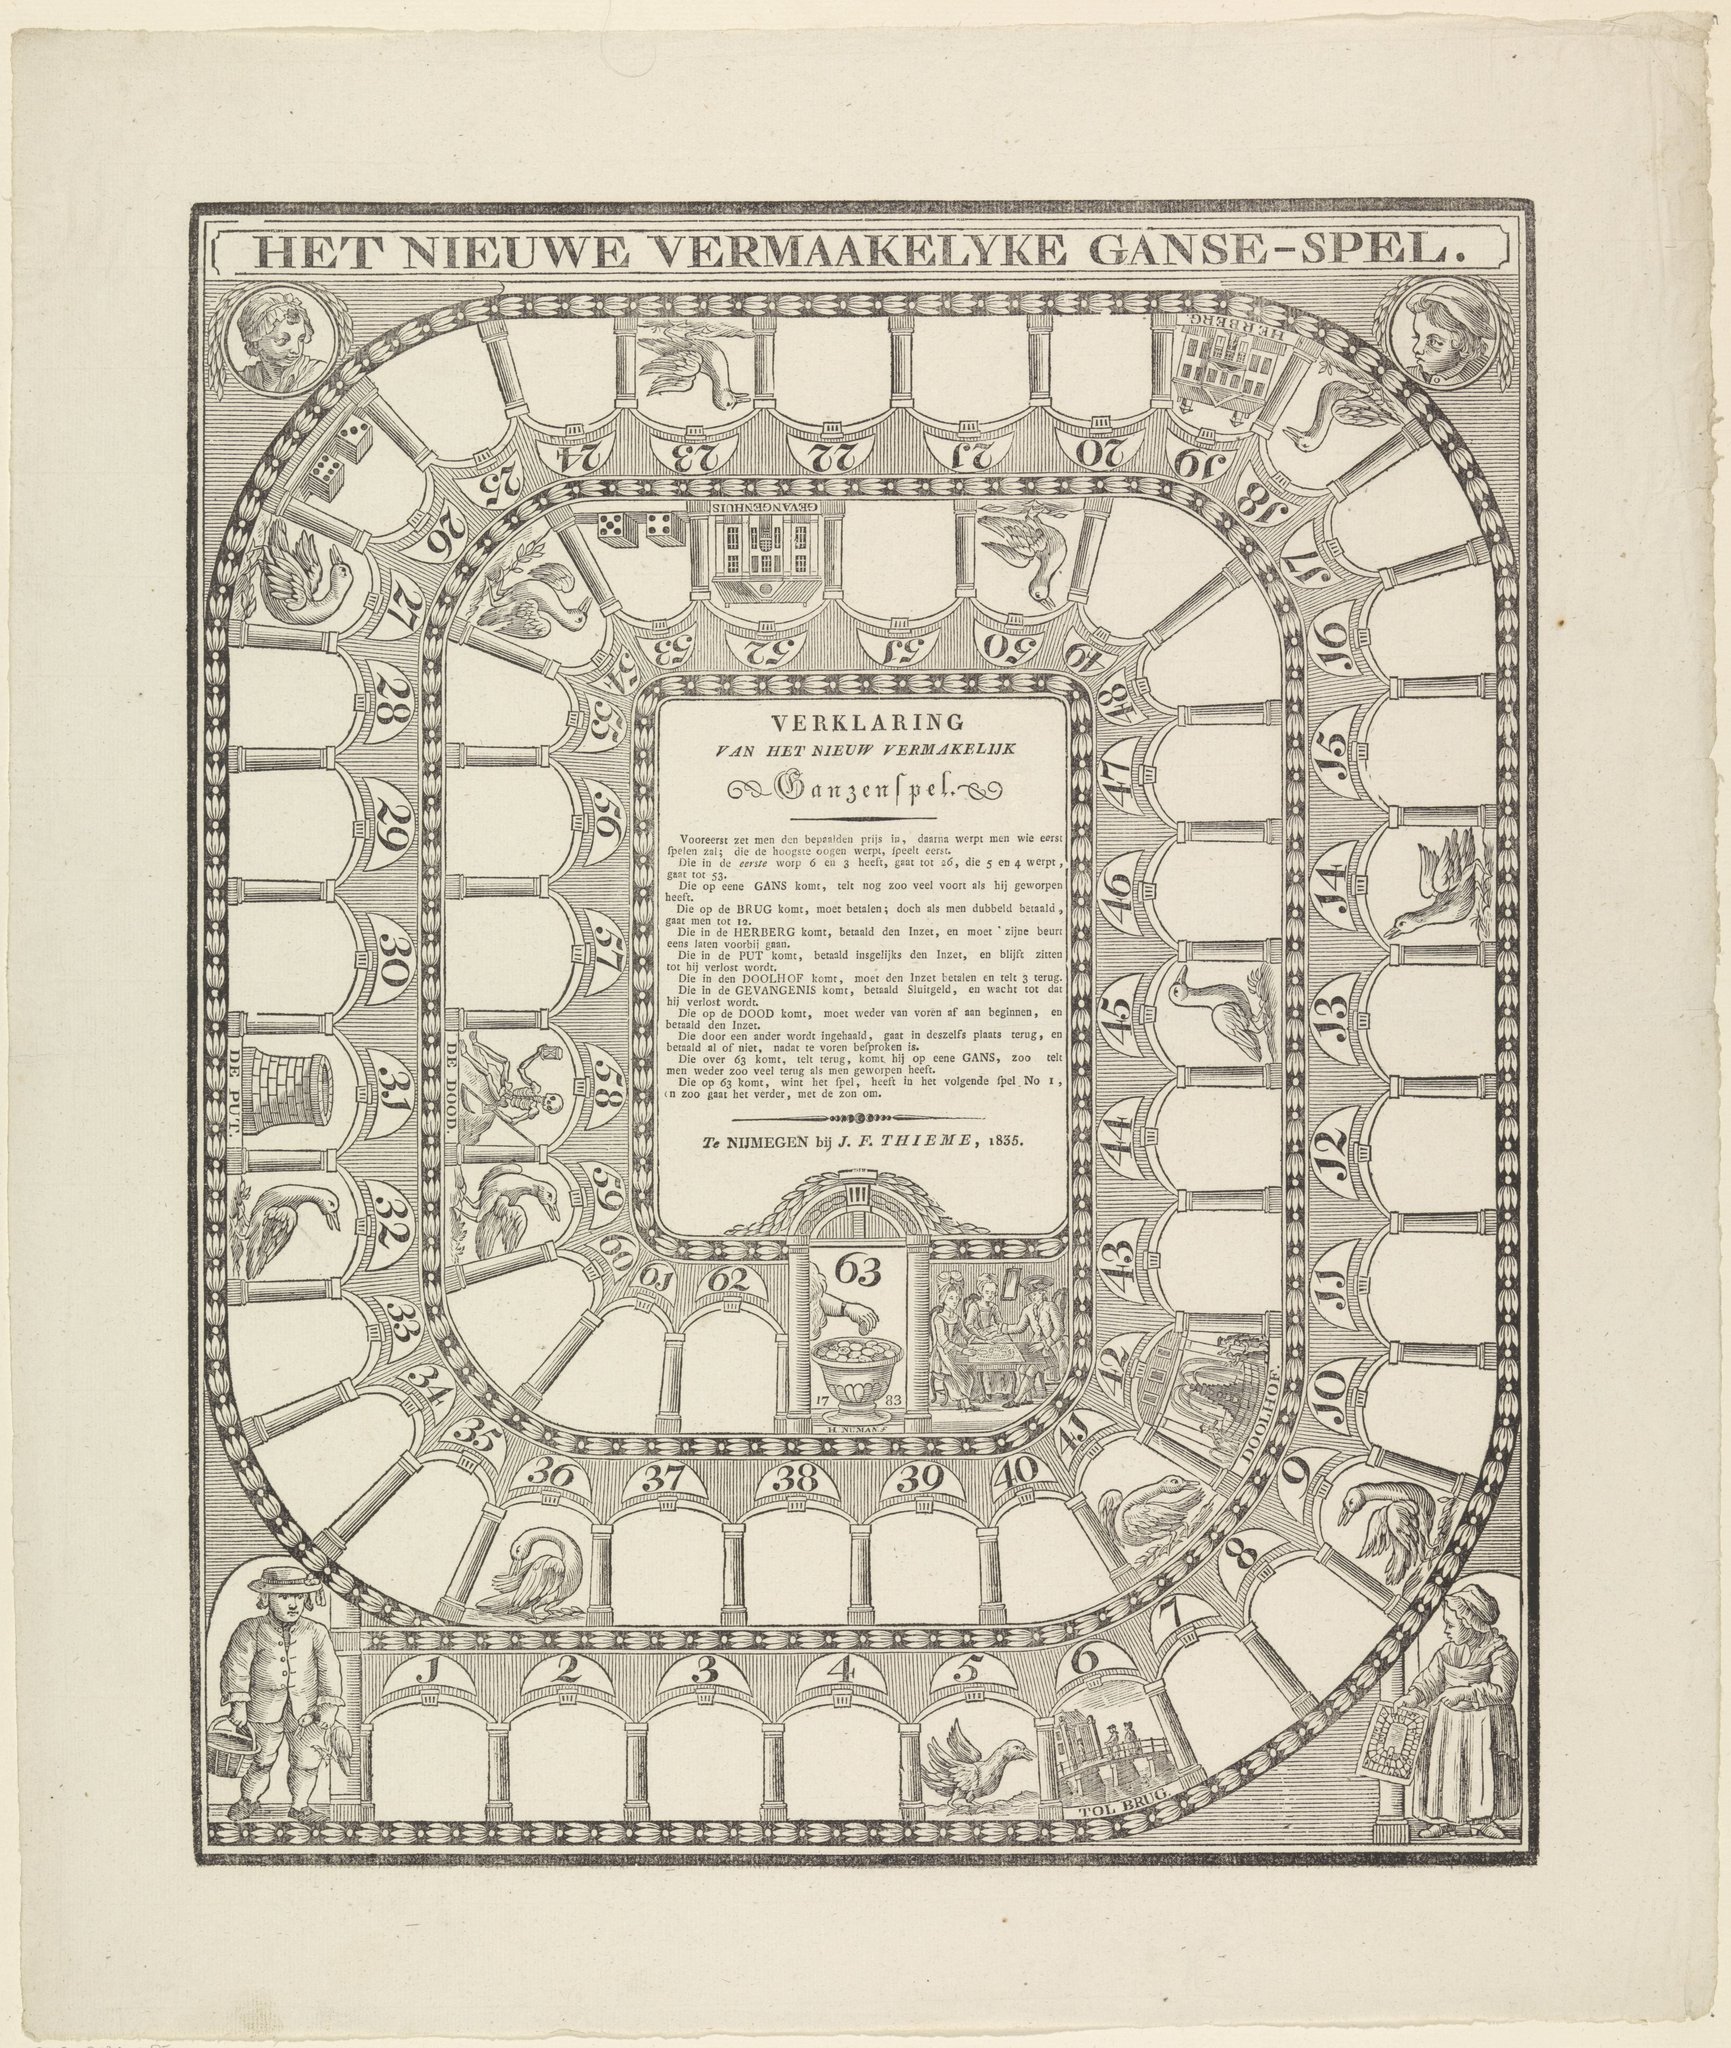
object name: gameboard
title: Het nieuwe vermaakelyke ganse-spel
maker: jan frederik thieme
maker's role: publisher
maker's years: 1799-1861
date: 1783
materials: paper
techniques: letterpress printing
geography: nijmegen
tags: goose-game, board-games of chance, board-games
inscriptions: collector's mark: Lugt 2760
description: Bordspel met spiraal met 63 genummerde vakjes. In verschillende vakjes een voorstelling van een gans. Op het middenveld de spelregels in boekdruk. In de bovenmarge de titel.